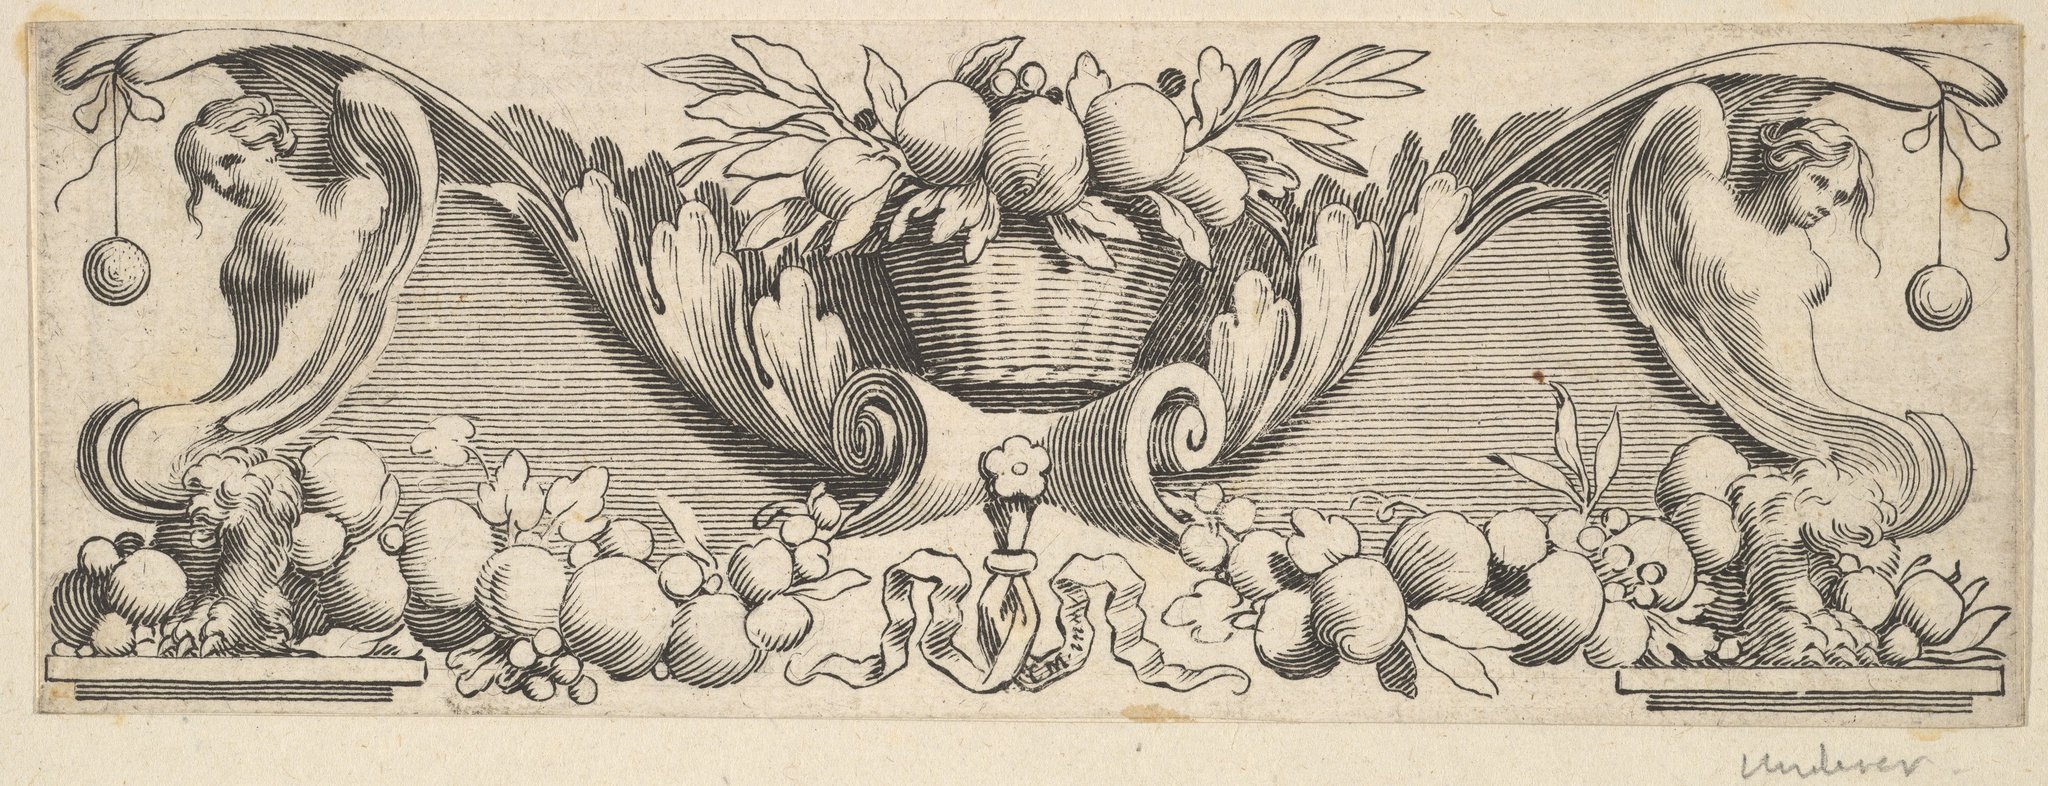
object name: print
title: Headband: Basket of Fruit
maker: claude mellan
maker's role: artist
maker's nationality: french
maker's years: 1598-1688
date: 1600-1688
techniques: etching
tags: fruit